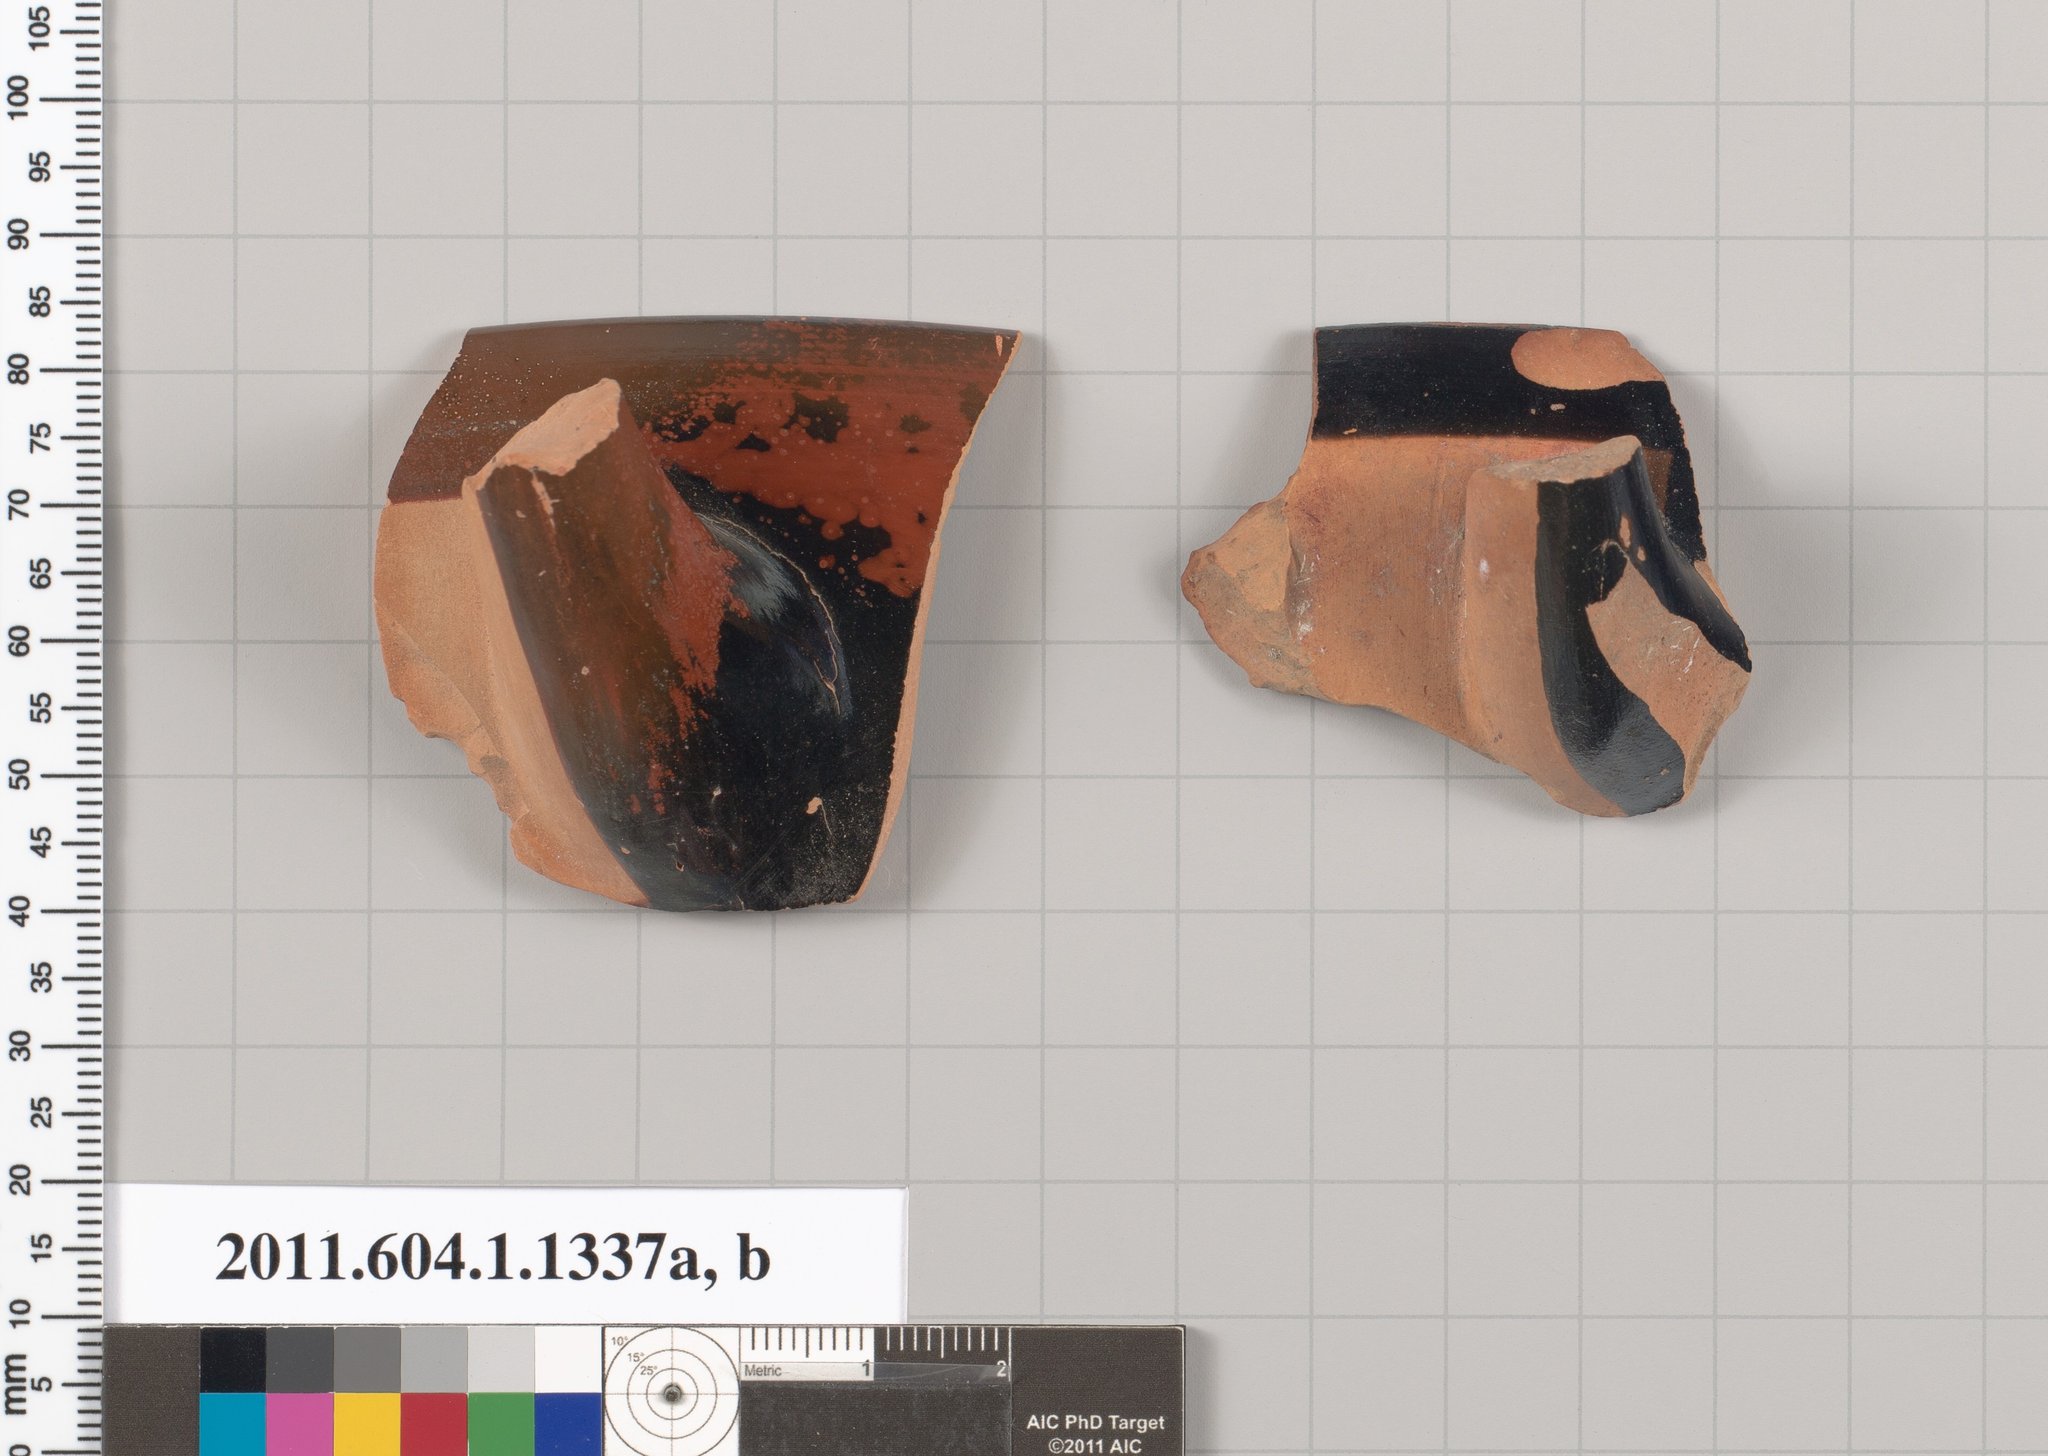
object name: kylix fragment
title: Terracotta fragments of kylikes (drinking cups)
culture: greek, attic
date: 500-401 BCE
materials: terracotta